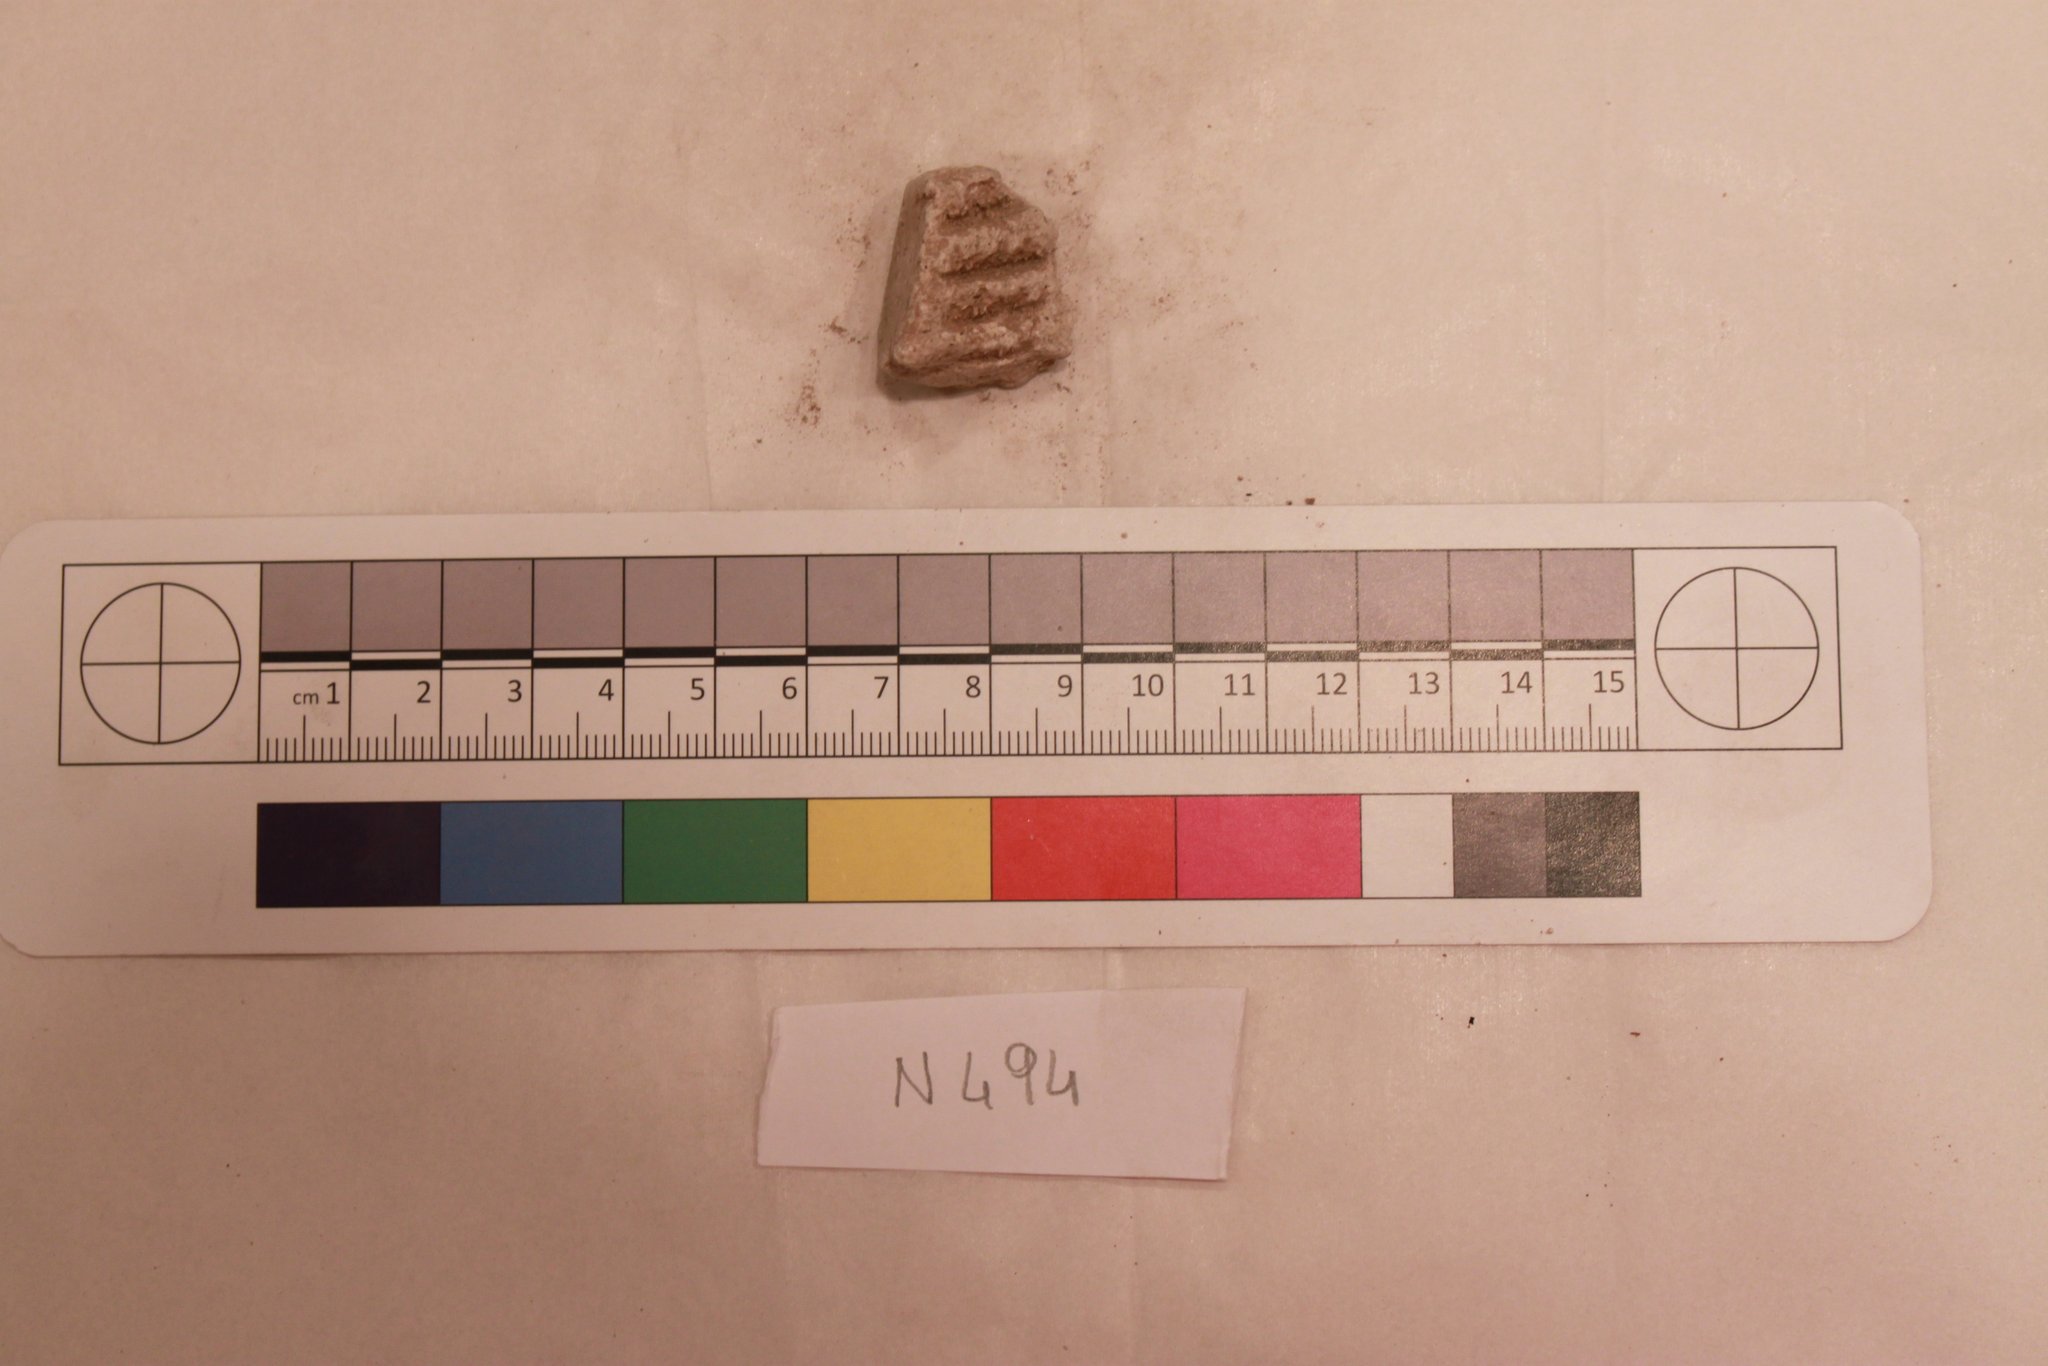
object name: fragment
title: Stucco Fragment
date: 701-1200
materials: plaster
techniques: carving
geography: iran